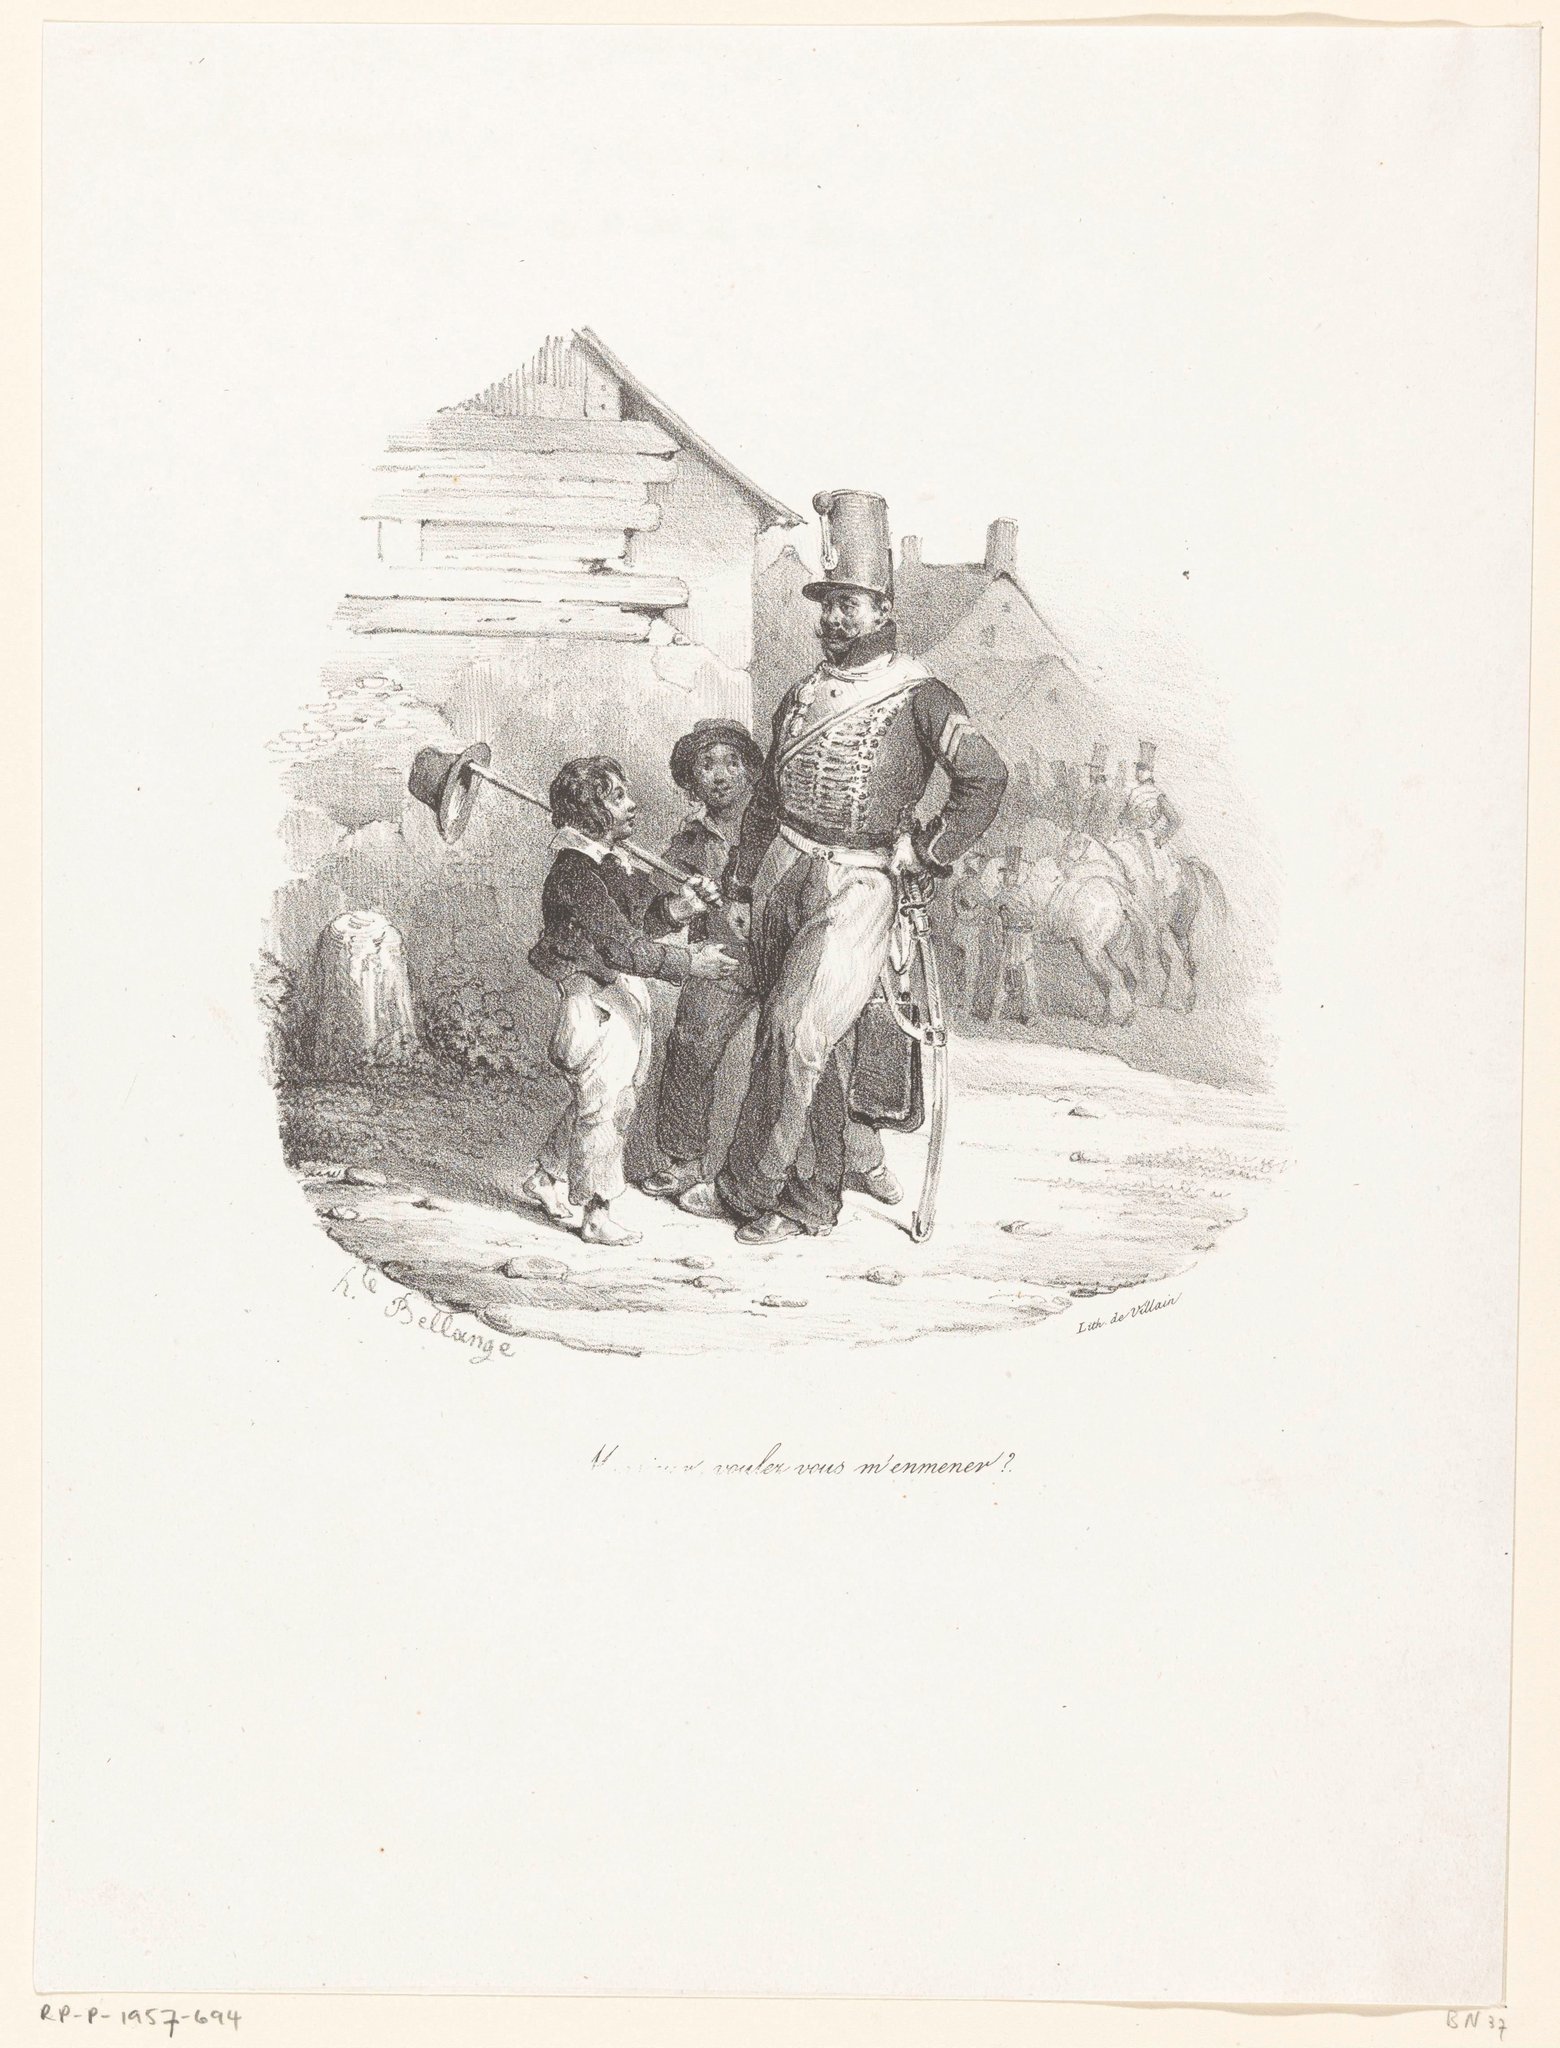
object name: print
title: Monsieur, voulez-vous m'emmener?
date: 1825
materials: paper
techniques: lithograph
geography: paris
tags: boy (child between toddler and youth), private soldier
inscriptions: collector's mark: Lugt 2228a